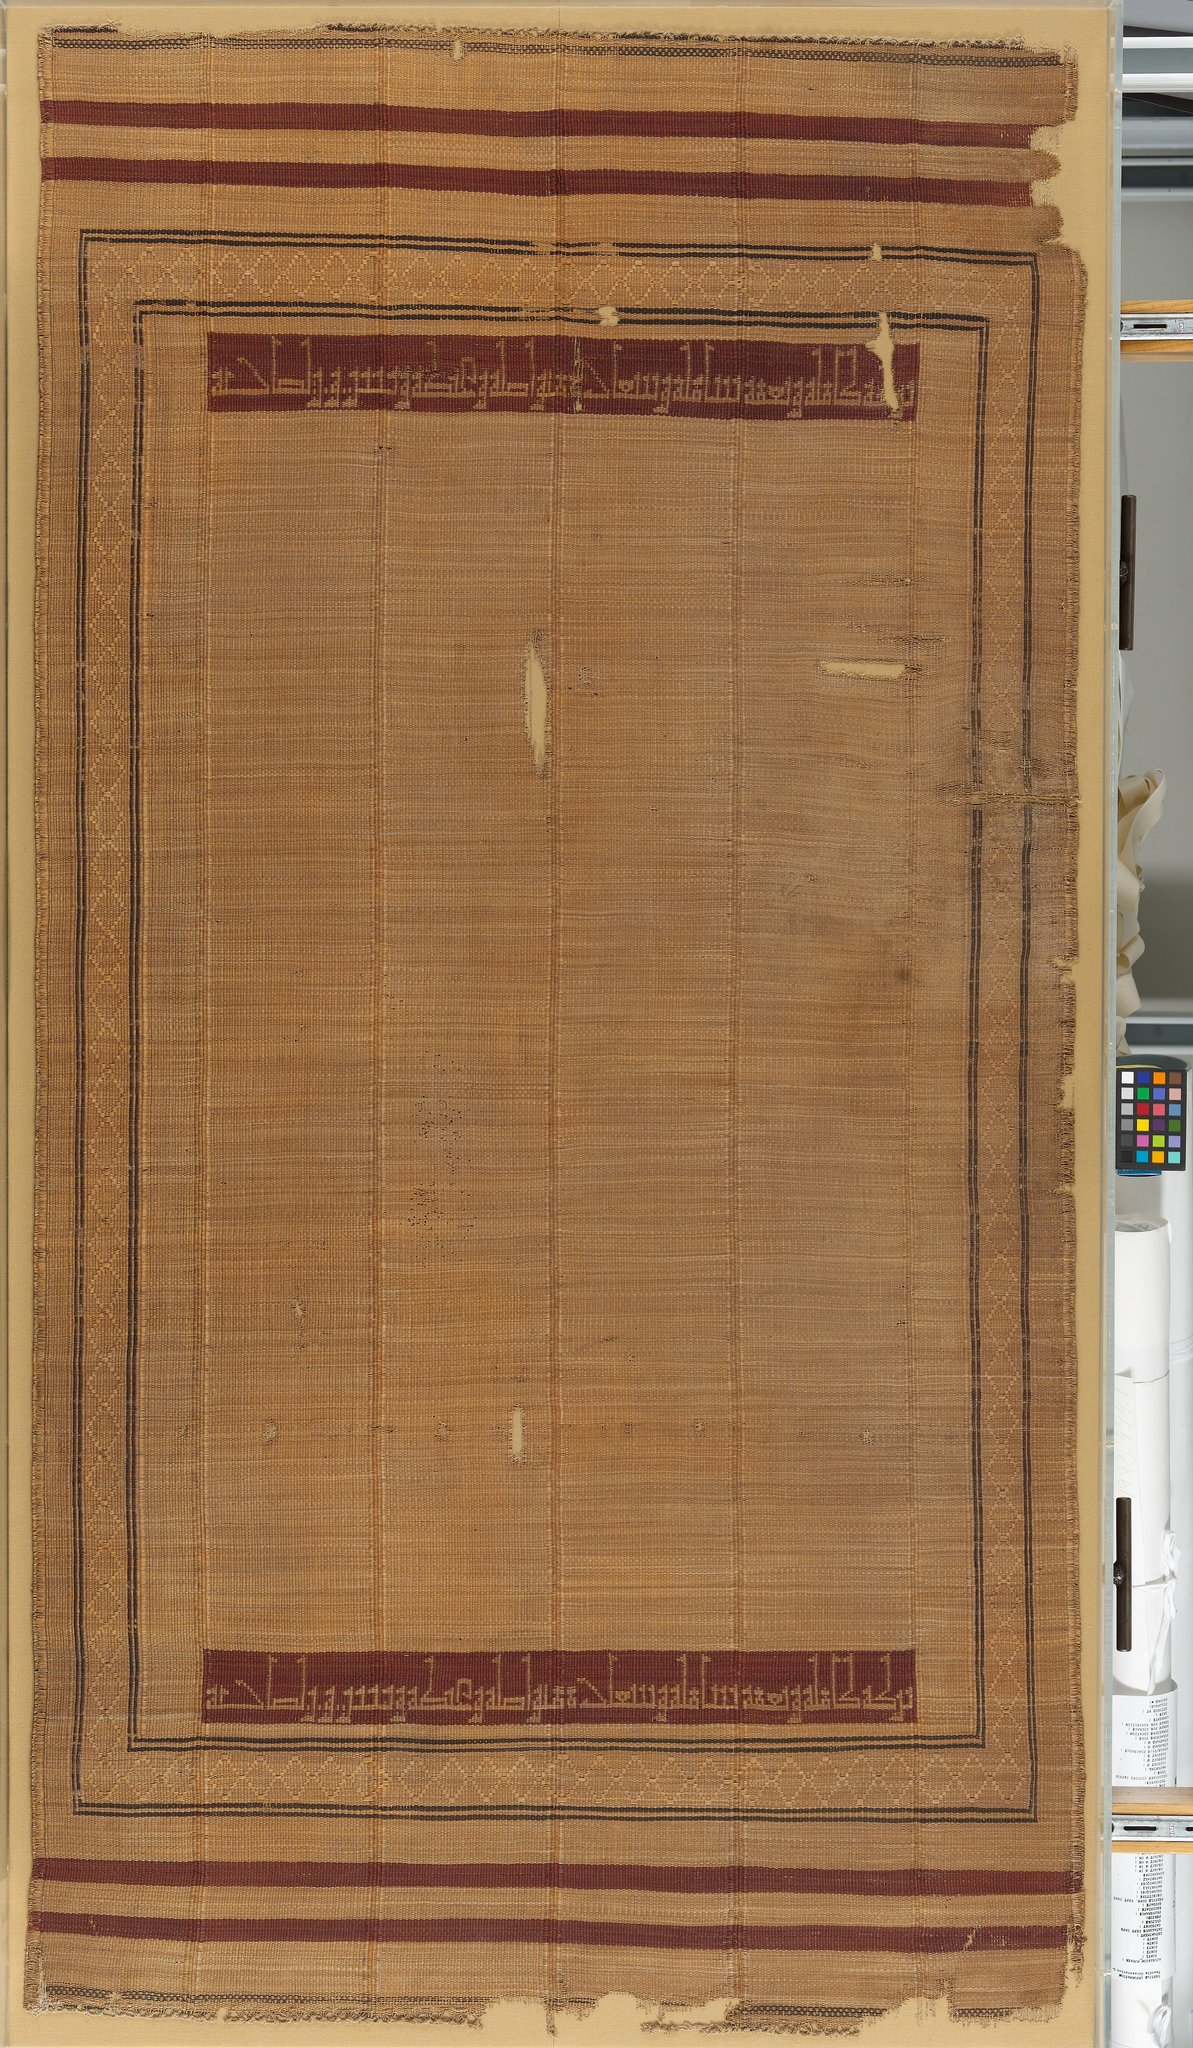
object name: mat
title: Reed Mat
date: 901-950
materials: hemp, fiber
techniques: brocade, weave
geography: israel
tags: arabic